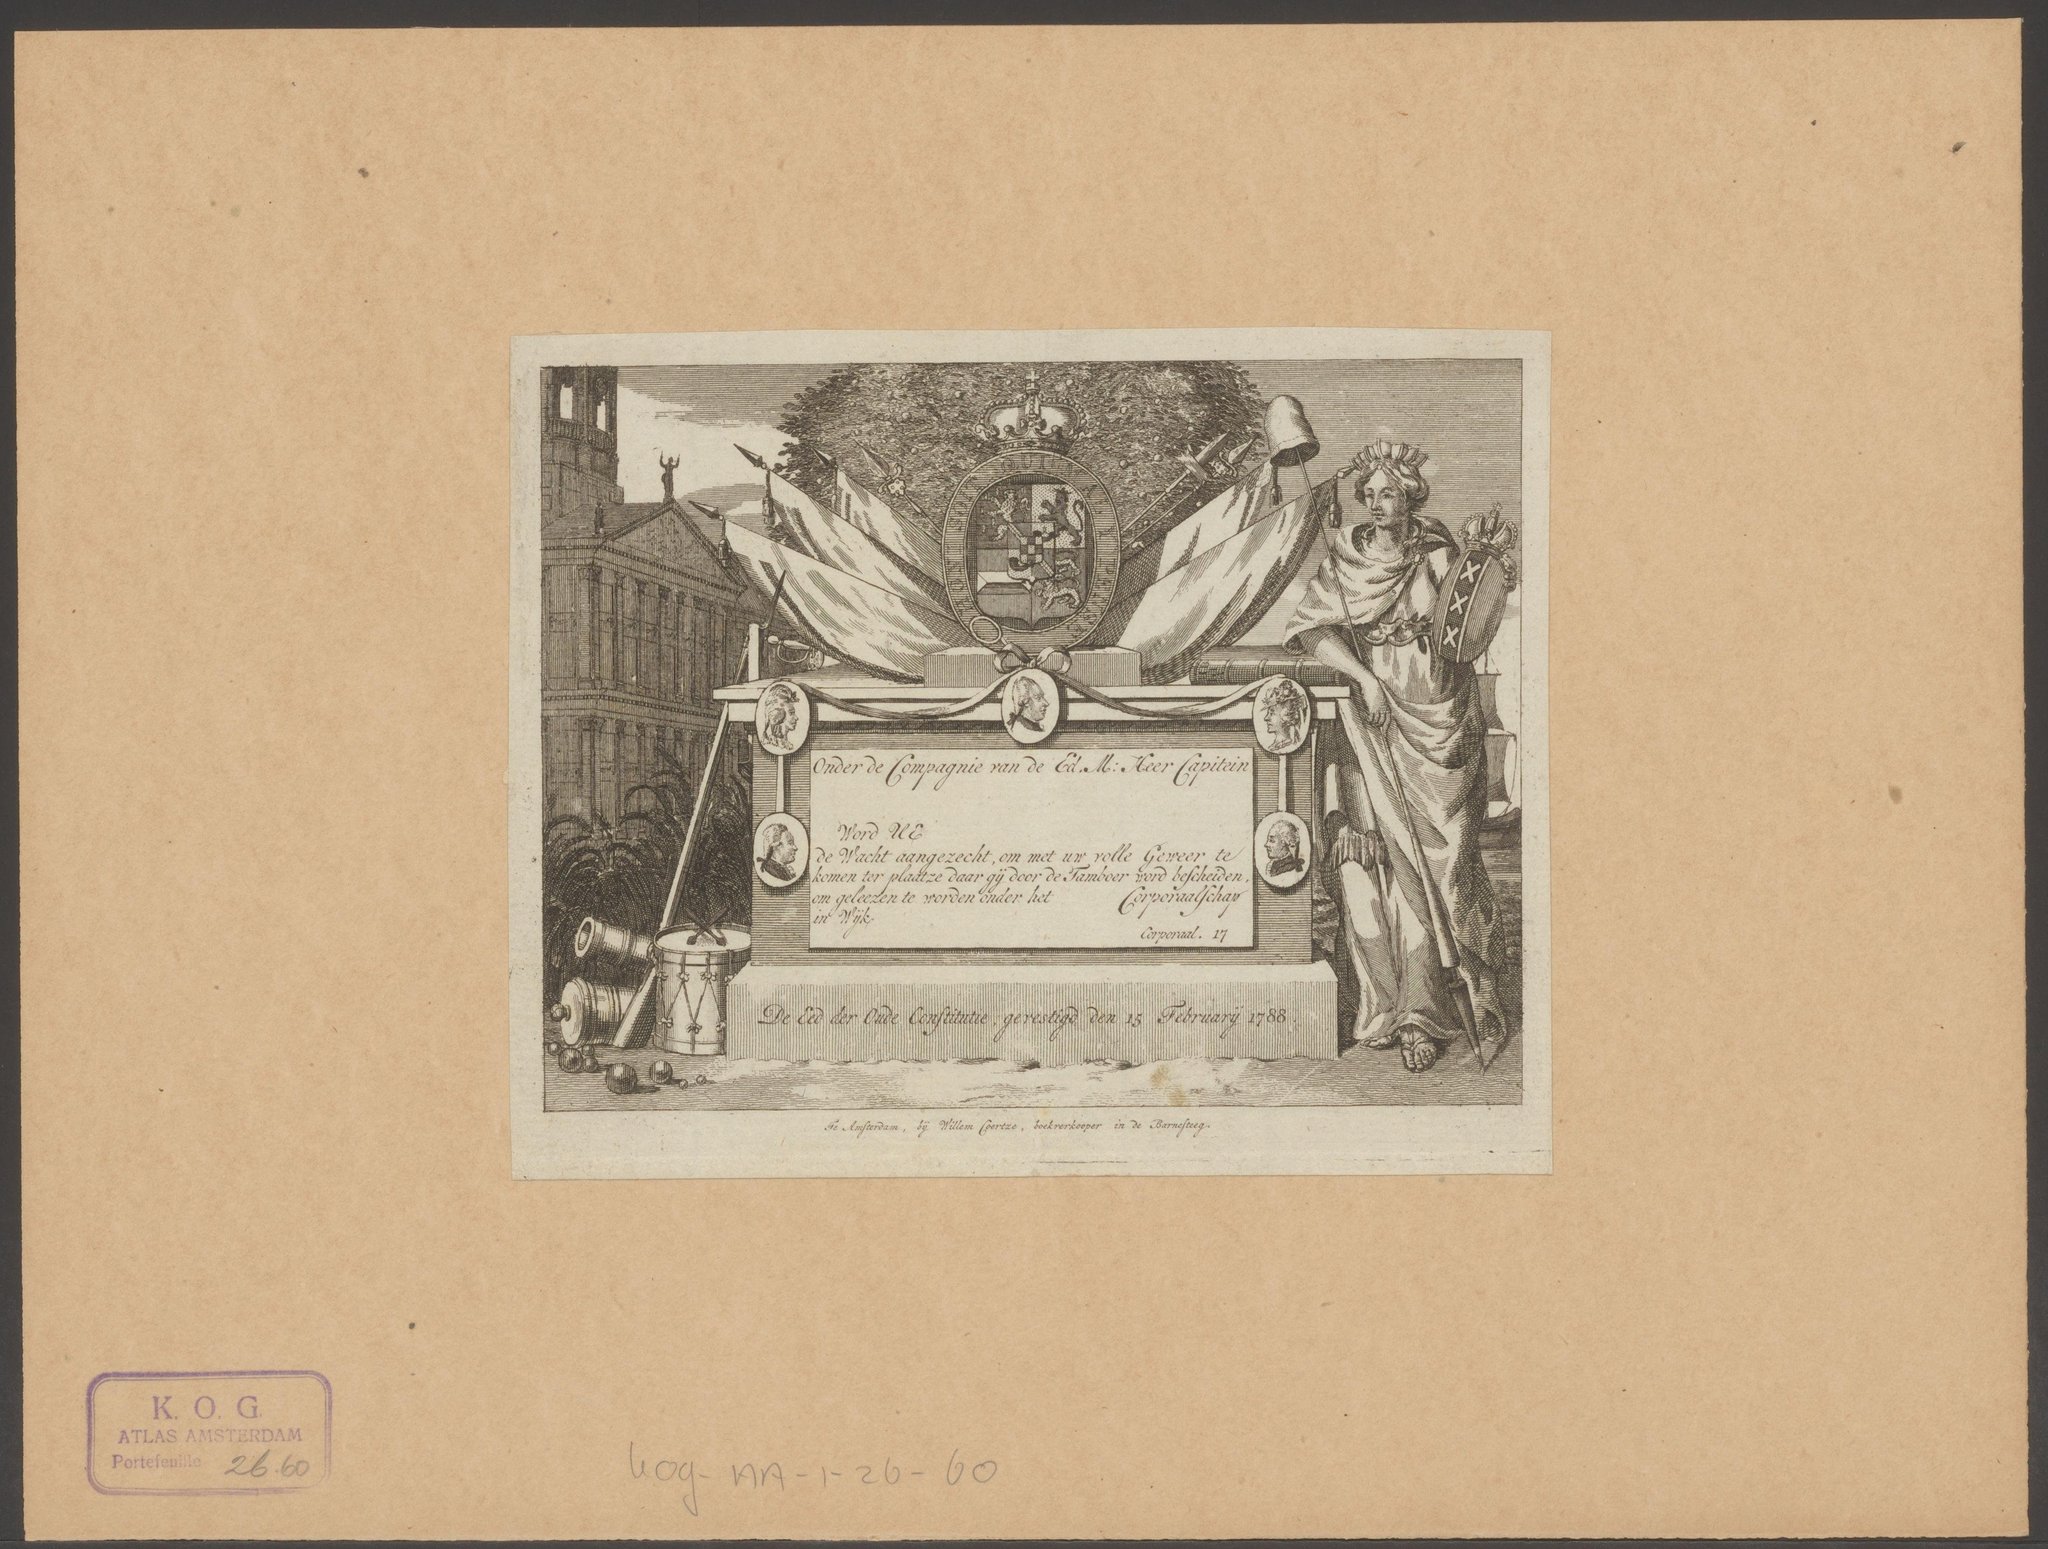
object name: print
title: Schuttersbrief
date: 1788-1789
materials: paper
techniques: engraving, etching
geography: amsterdam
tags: coat of arms (symbol of sovereignty), coat of arms (as symbol of the state, etc.) (+ city; municipal), personification of a city, town-patron(ess), amsterdam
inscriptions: collector's mark: Lugt 1641b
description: Onderwerpsrubriek binnen de Atlas Amsterdam: Schutters-oproepingsbriefjes.